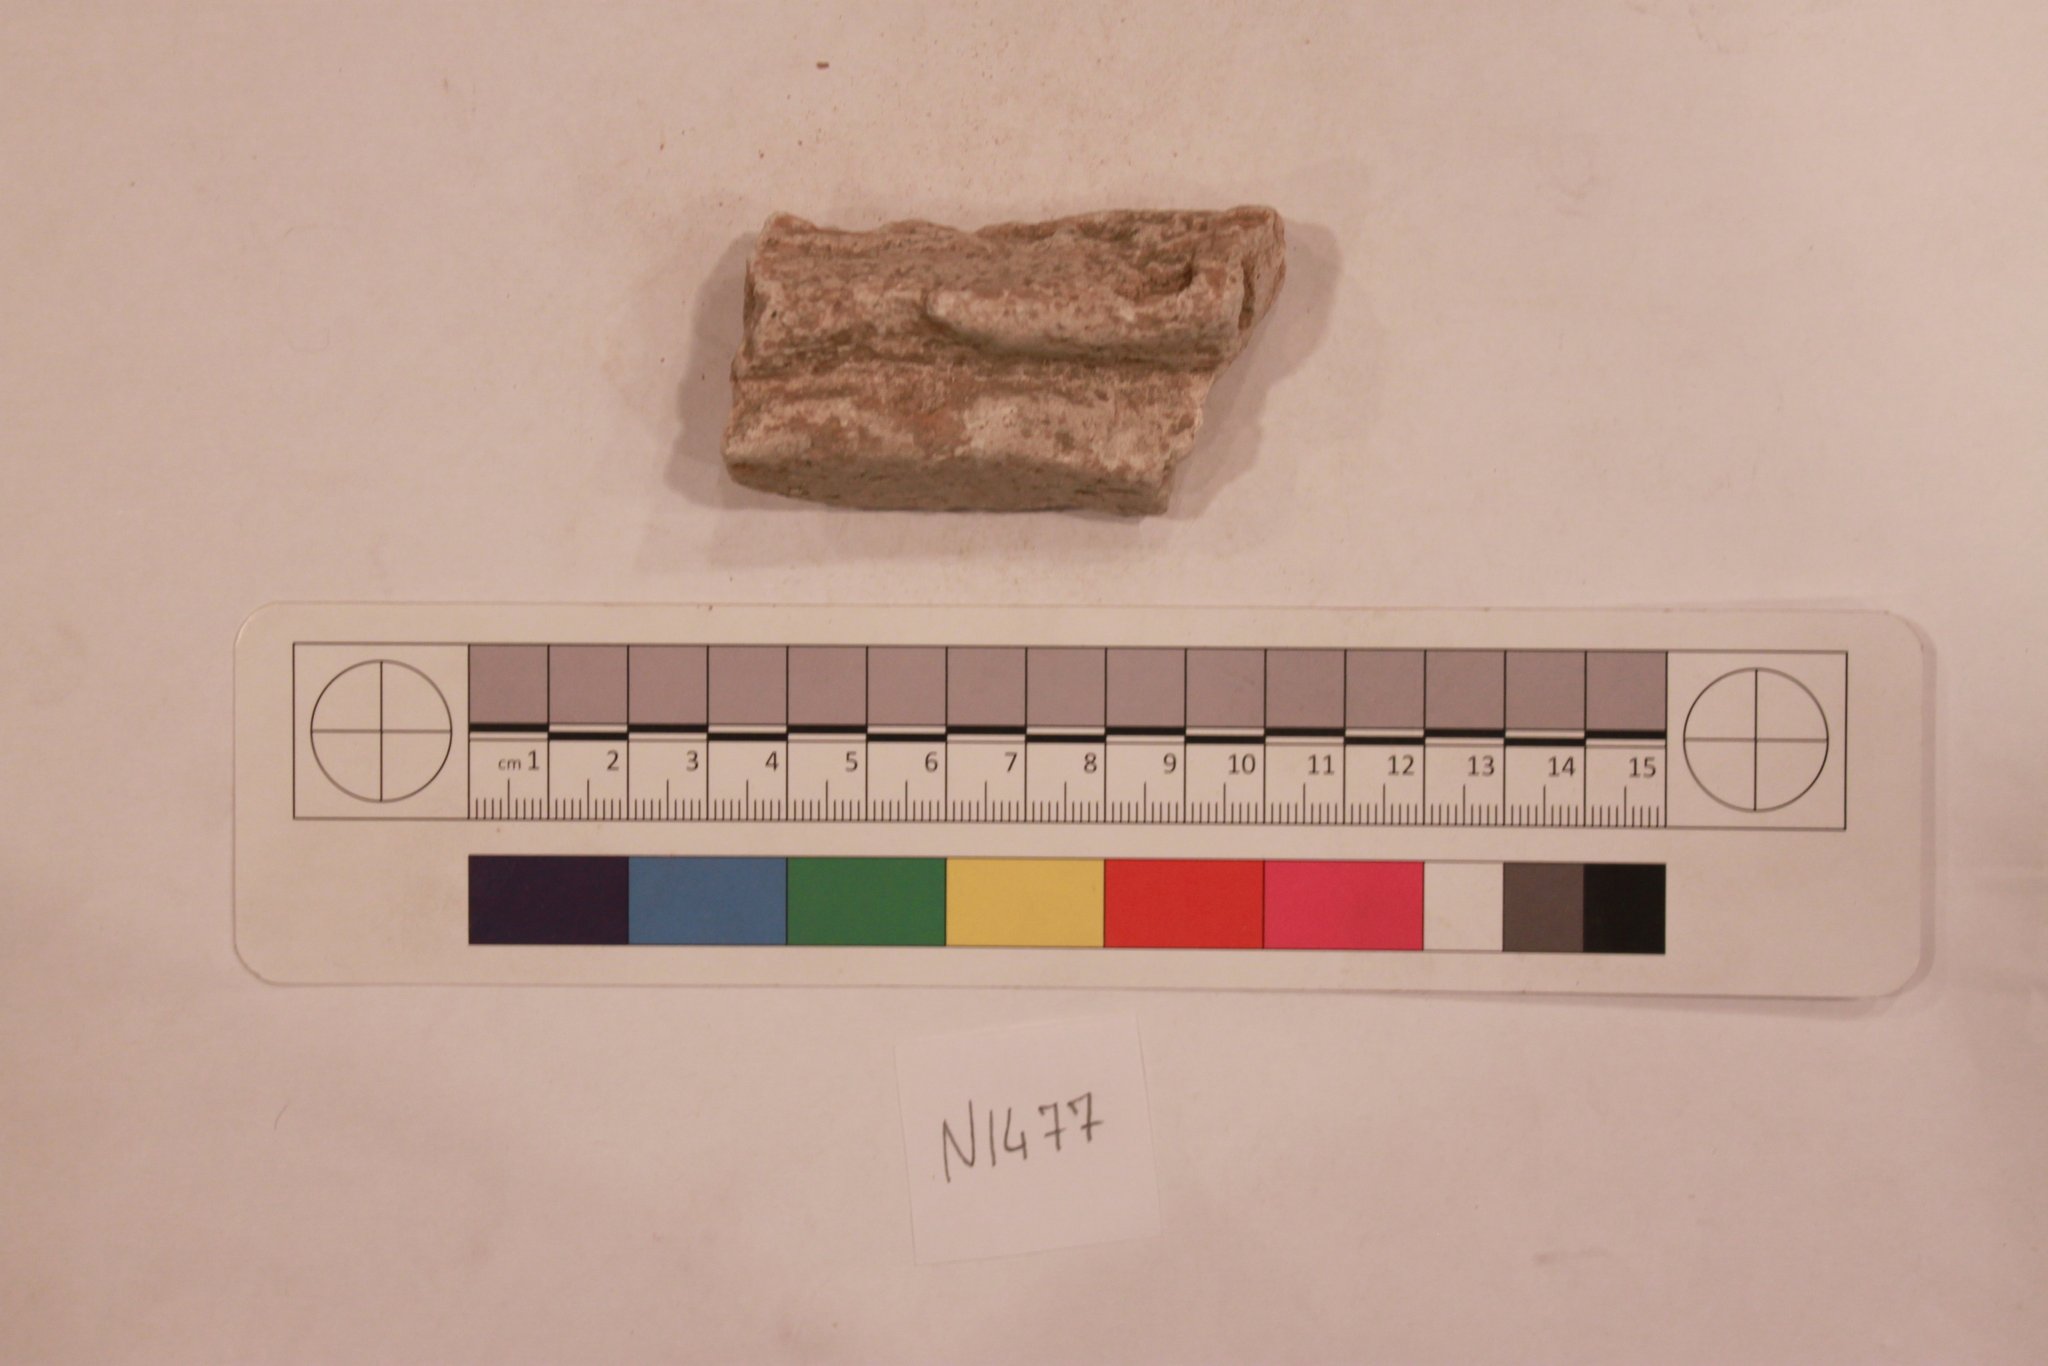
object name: fragment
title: Stucco Fragment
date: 701-1200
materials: plaster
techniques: carving, painting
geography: iran